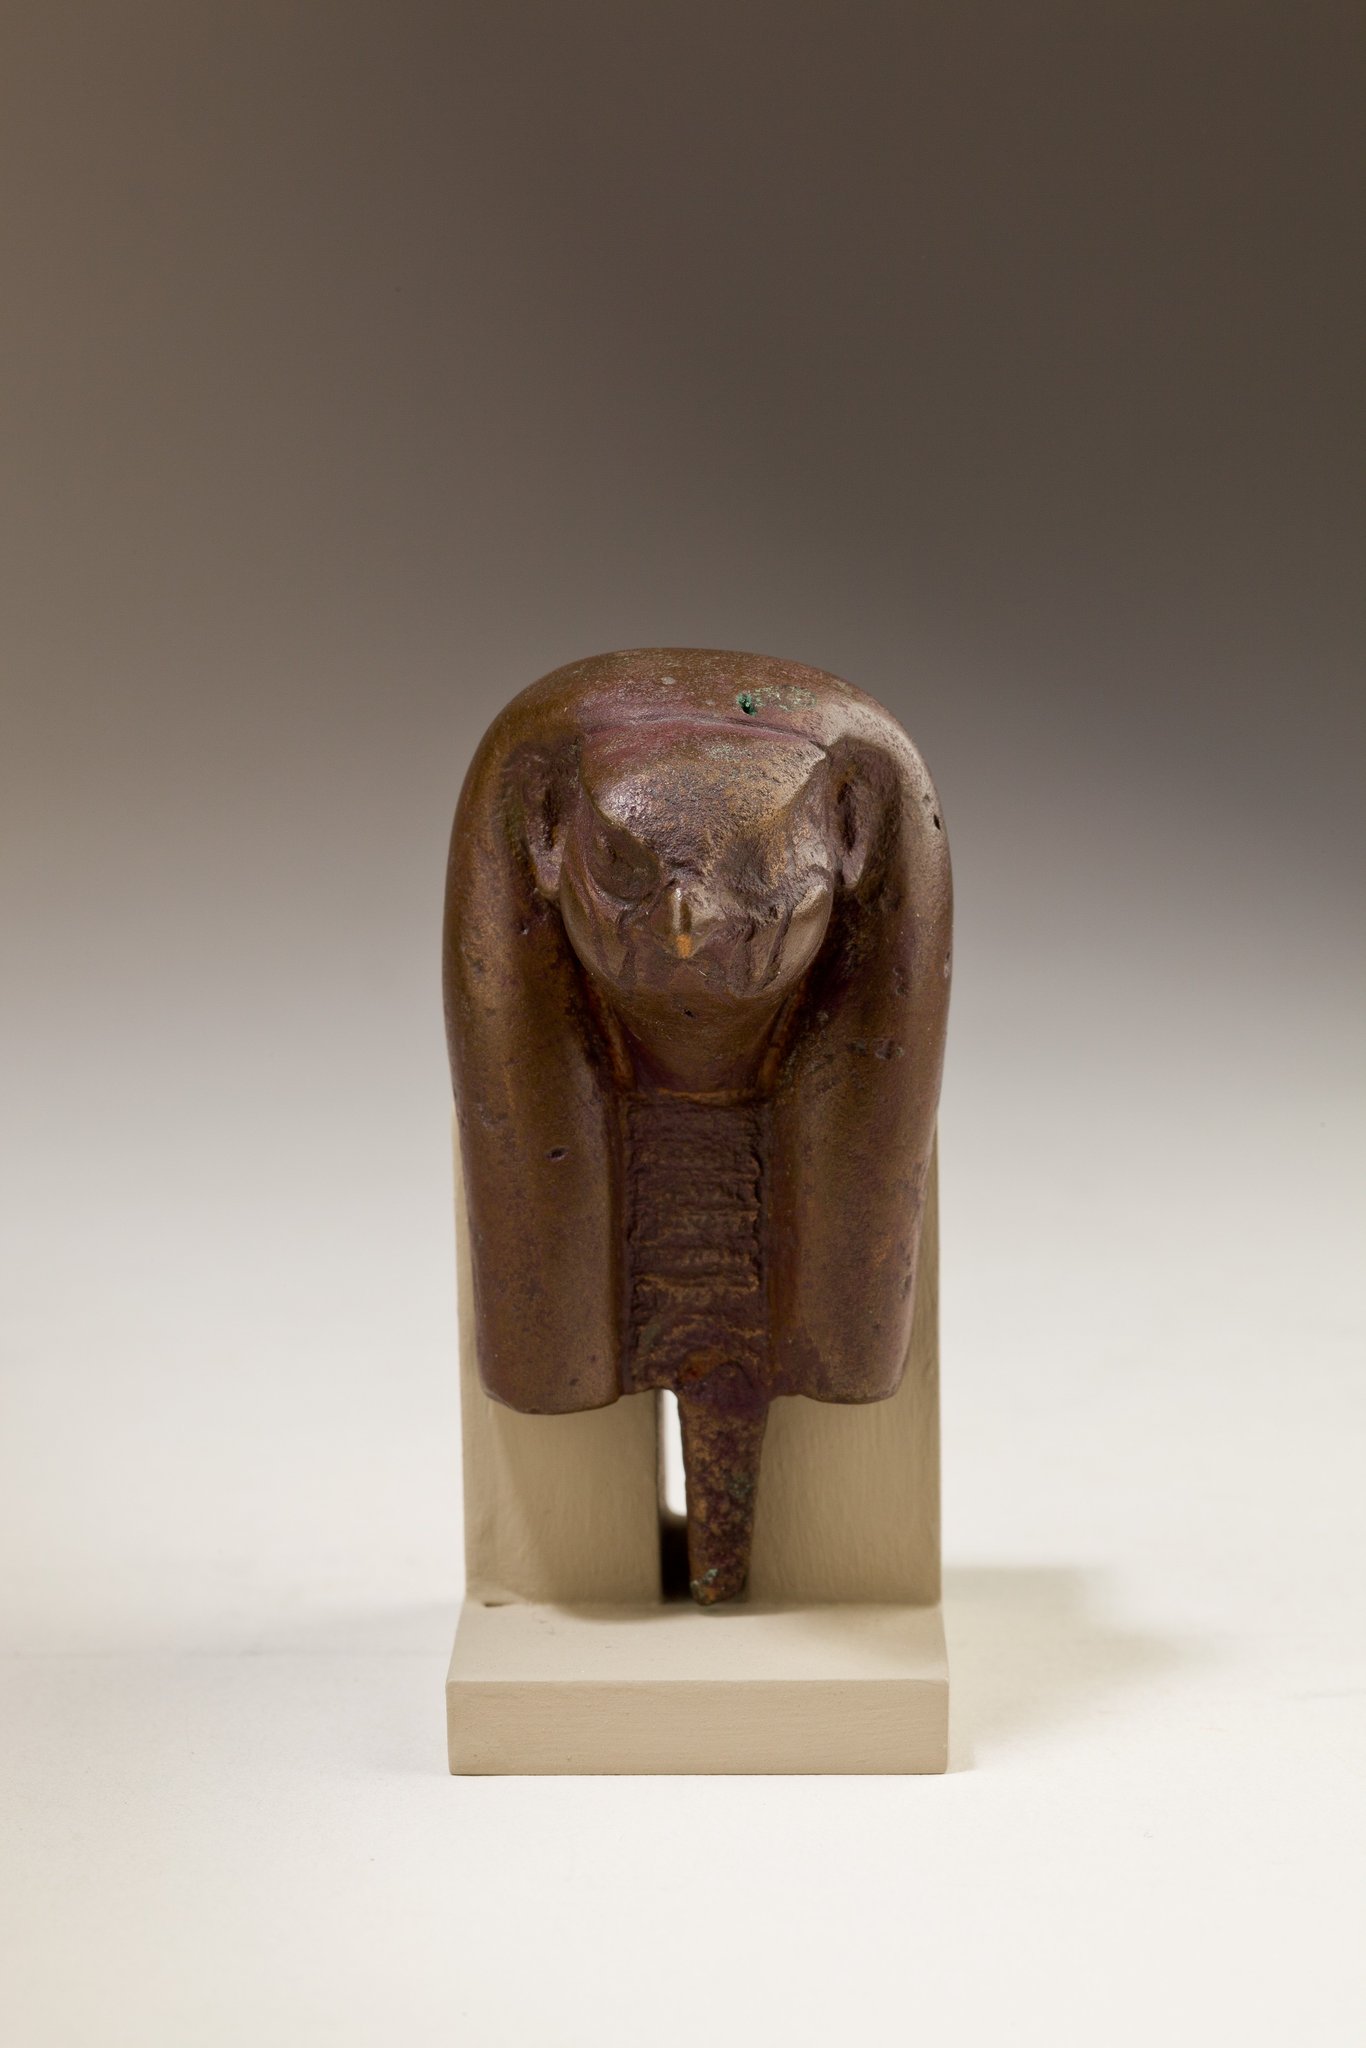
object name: shrine attachment, falcon head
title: Falcon head, fitting from furniture or shrine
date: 712-343 BCE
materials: metal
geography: egypt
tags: falcons